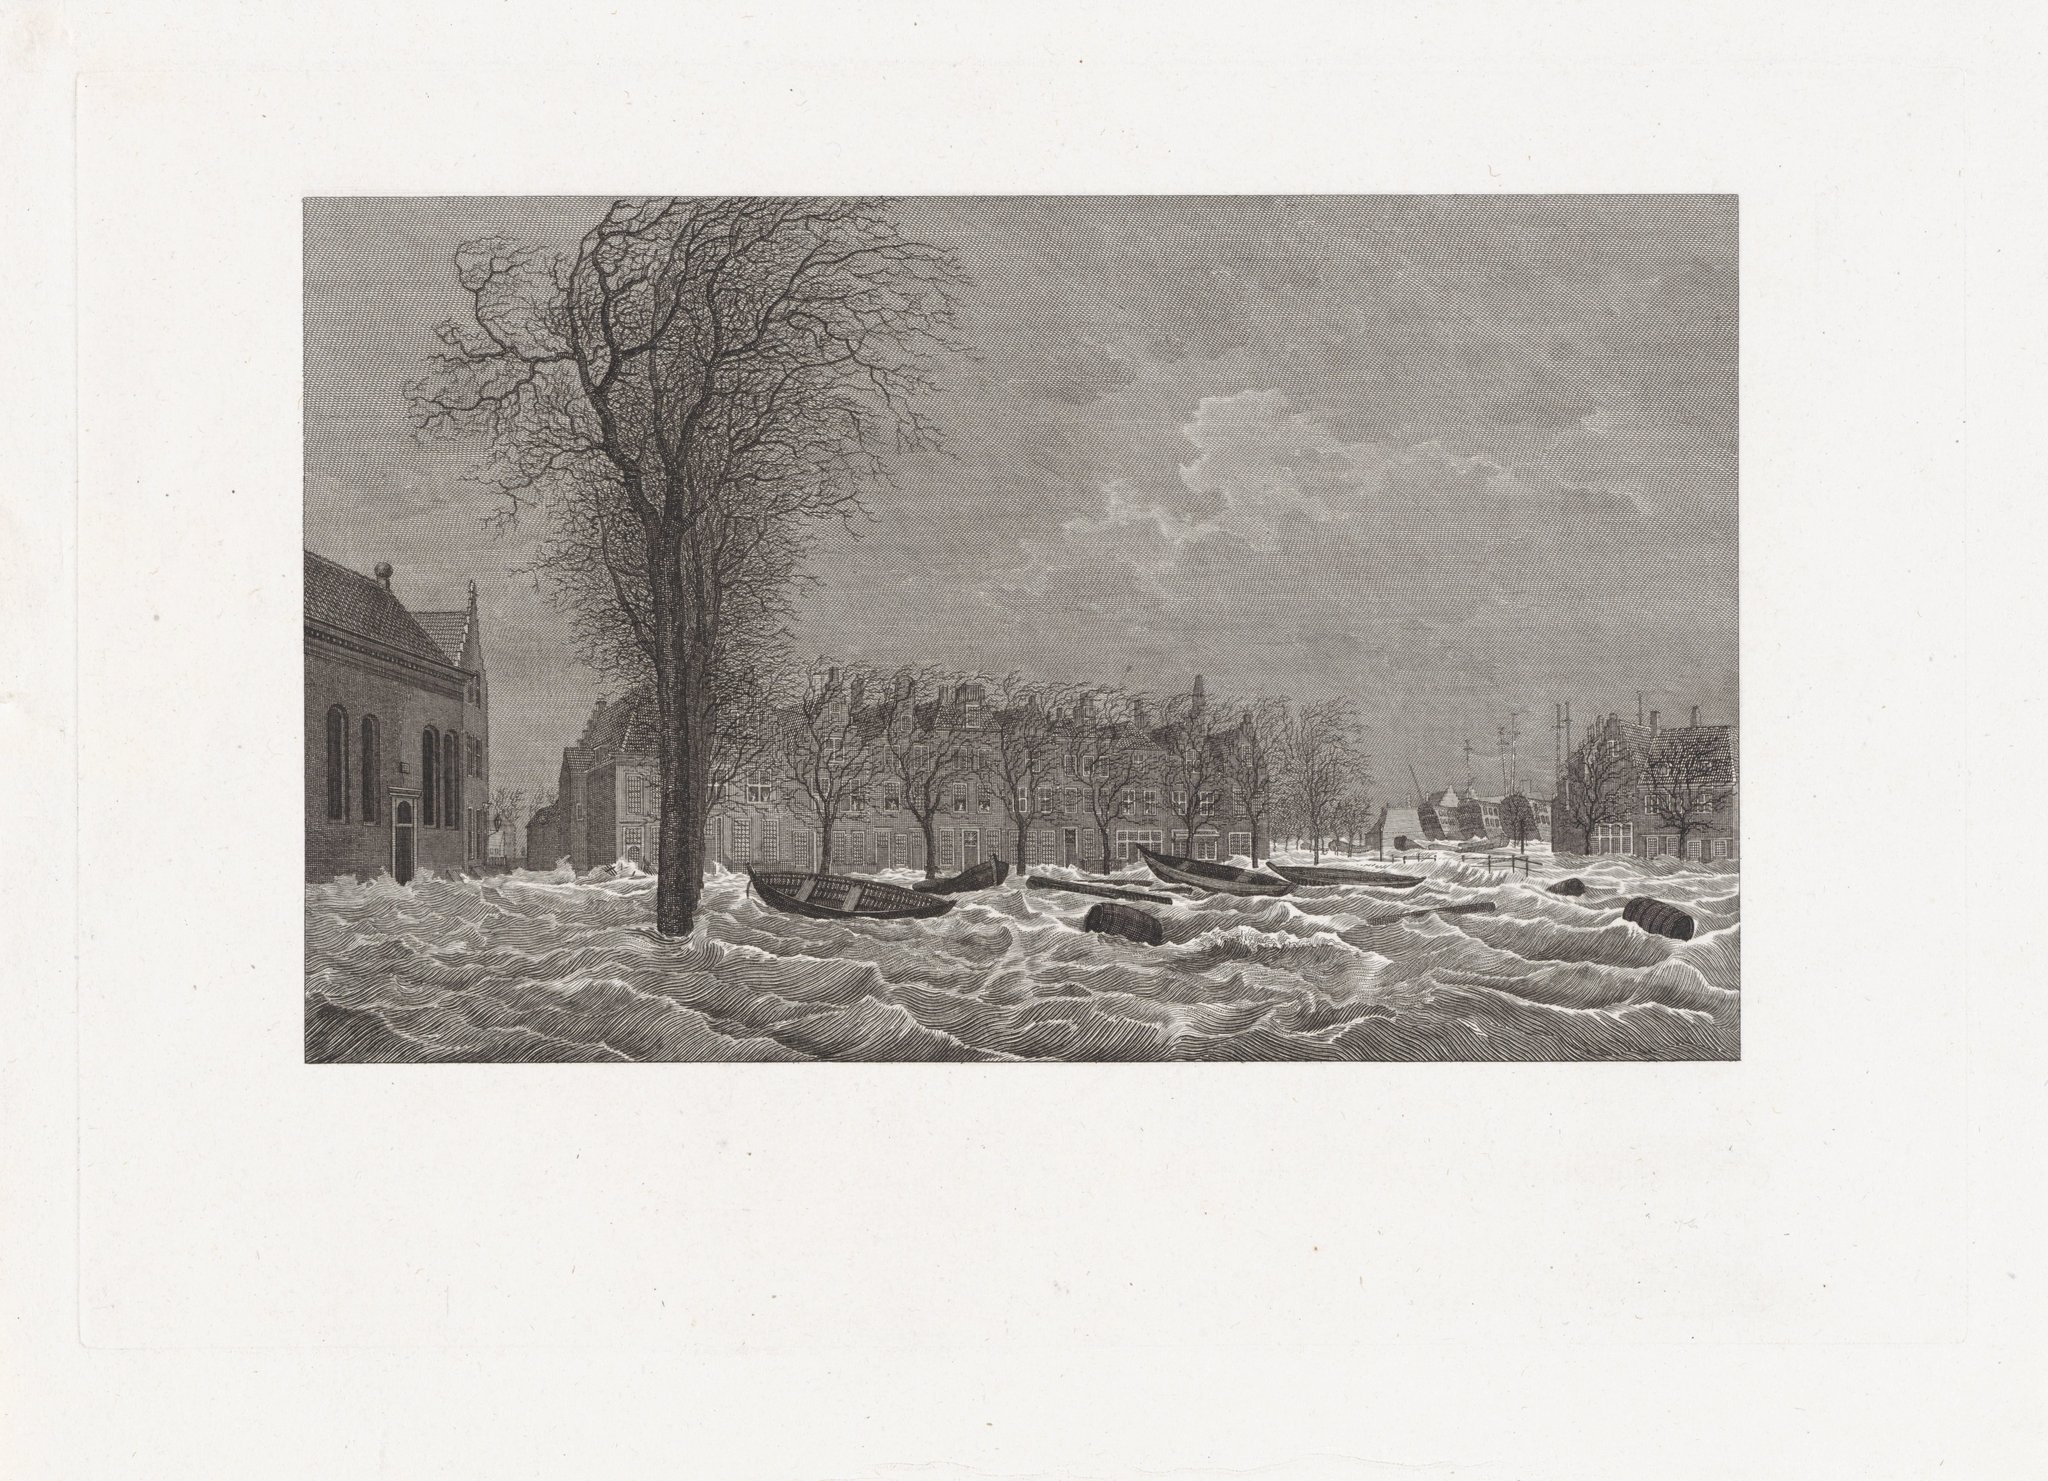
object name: print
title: Overstroming bij de Kerkstraat, Steen Beer en Dok te Vlissingen, 1808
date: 1808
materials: paper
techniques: etching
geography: haarlem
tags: flood, flushing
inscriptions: collector's mark: Lugt Lugt 2228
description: Latere staat prent gebruikt in: Hoek, S. van. Natuur- en geschiedkundige beschrijving van den verschrikkelijken watervloed tusschen den XIVden en XVden van Louwmaand des jaars 1808. Haarlem: Adriaan Pietersz. Loosjes, 1808.